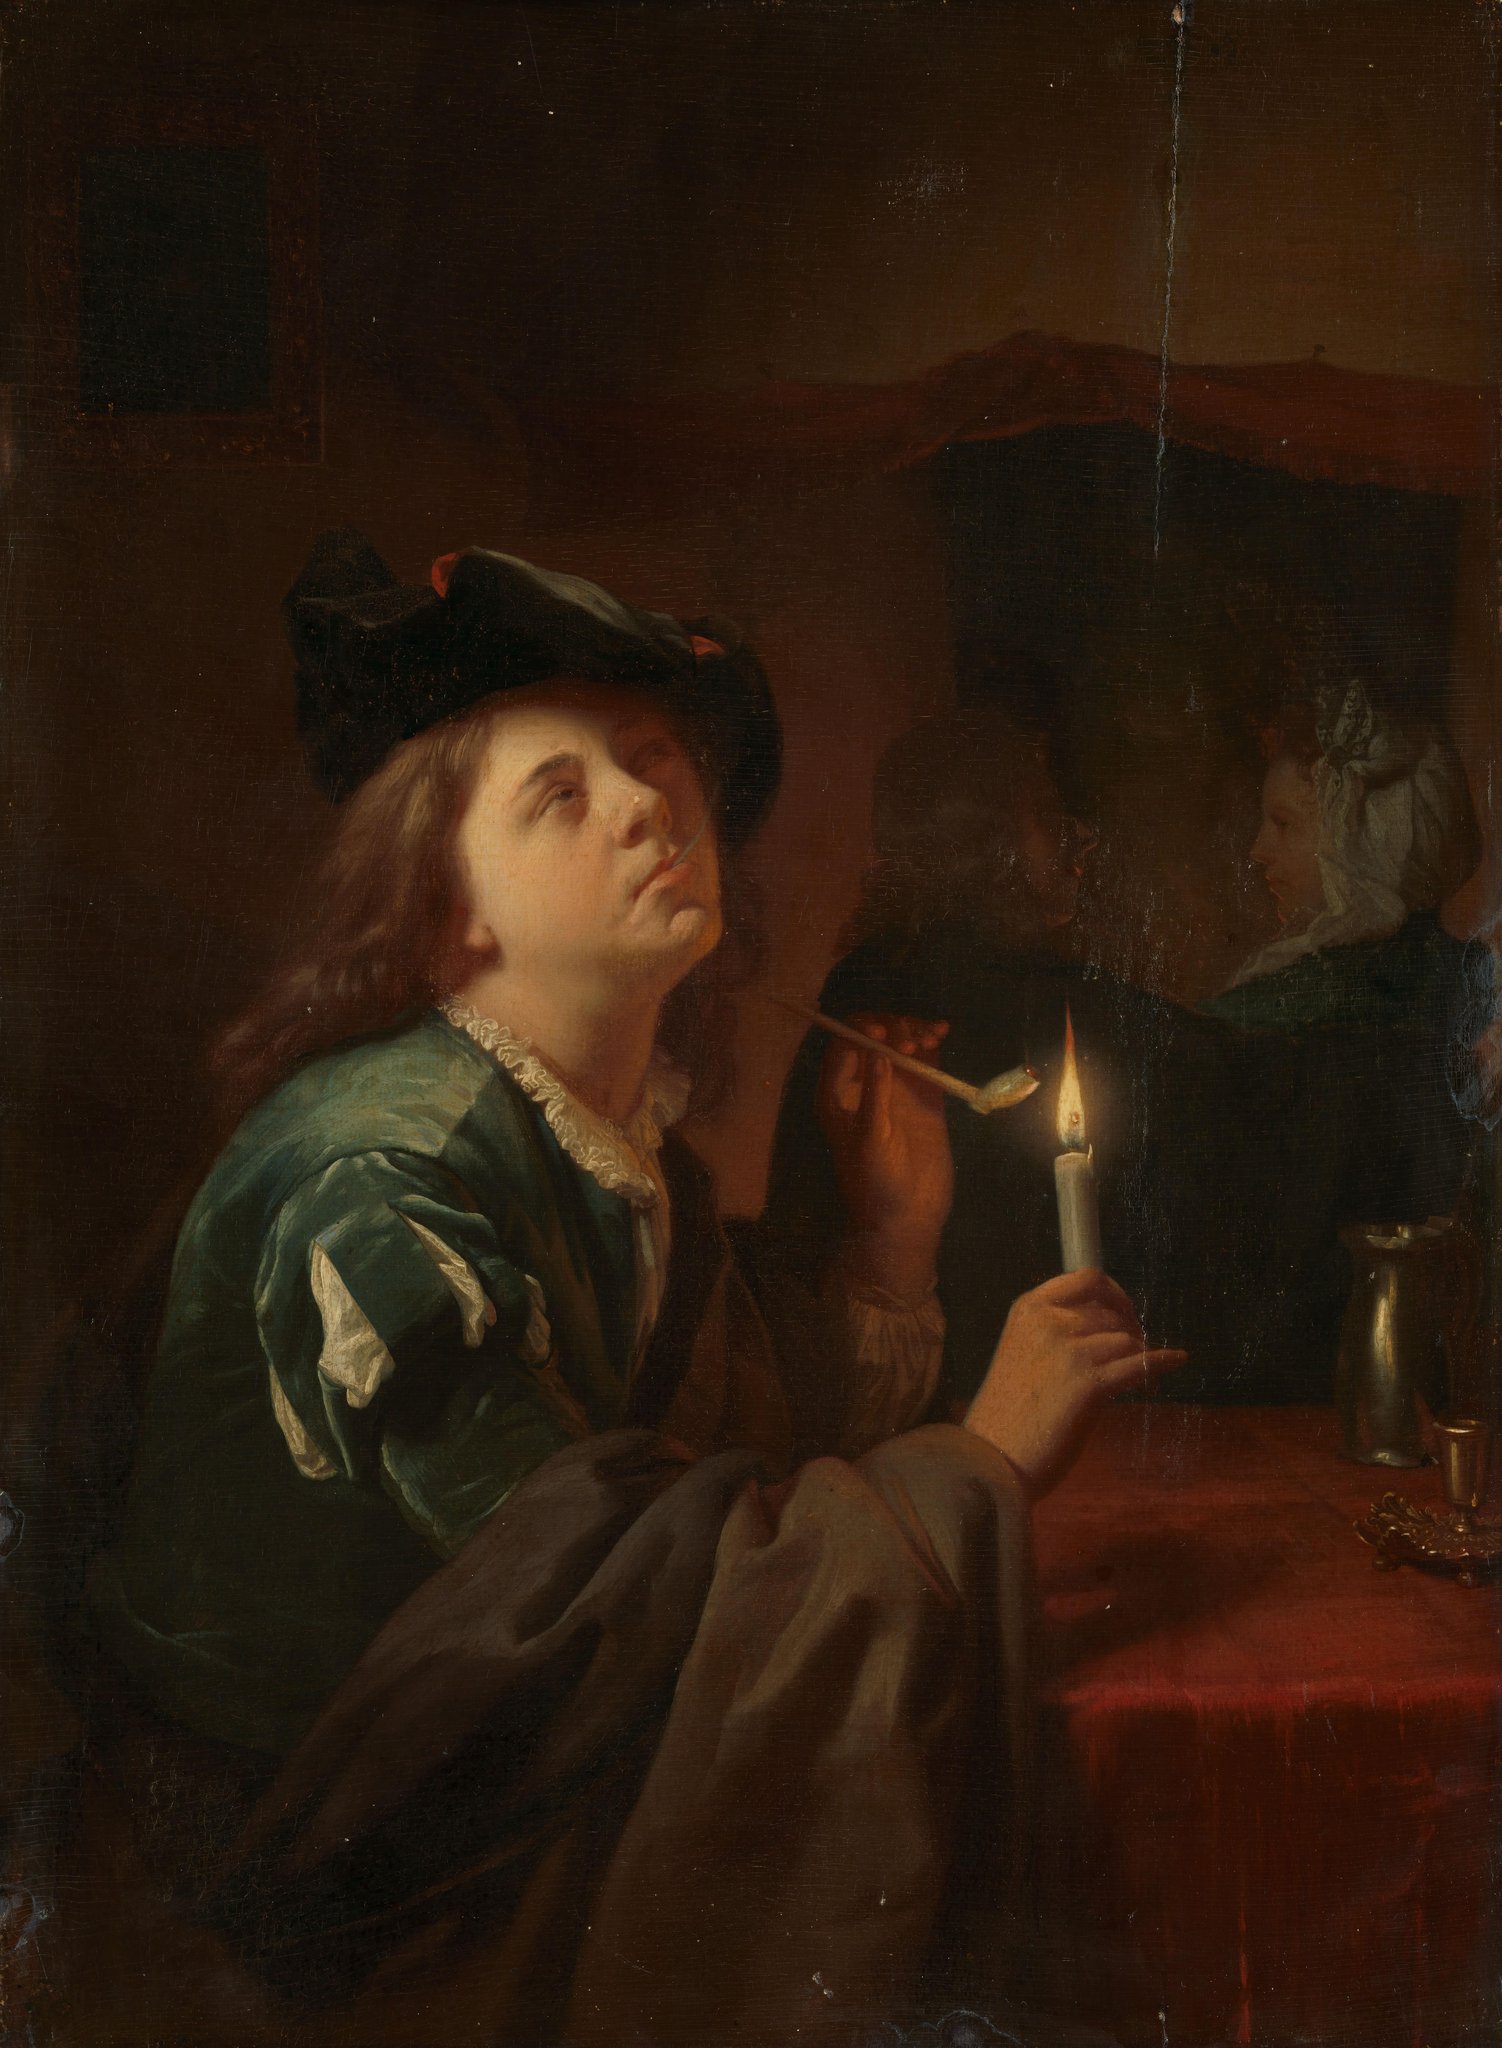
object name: painting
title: 'Differing tastes'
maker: godfried schalcken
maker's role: draughtsman, painter, print maker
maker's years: 1643-1706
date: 1685-1690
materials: oil, panel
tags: pipe ~ tobacco, candle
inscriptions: signature: ‘G. Schalck’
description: Voorstelling getiteld 'Verschil van smaak'. Een man heeft met een kaars zijn pijp aangestoken, op de achtergrond een man en een vrouw. Pendant van SK-A-368.